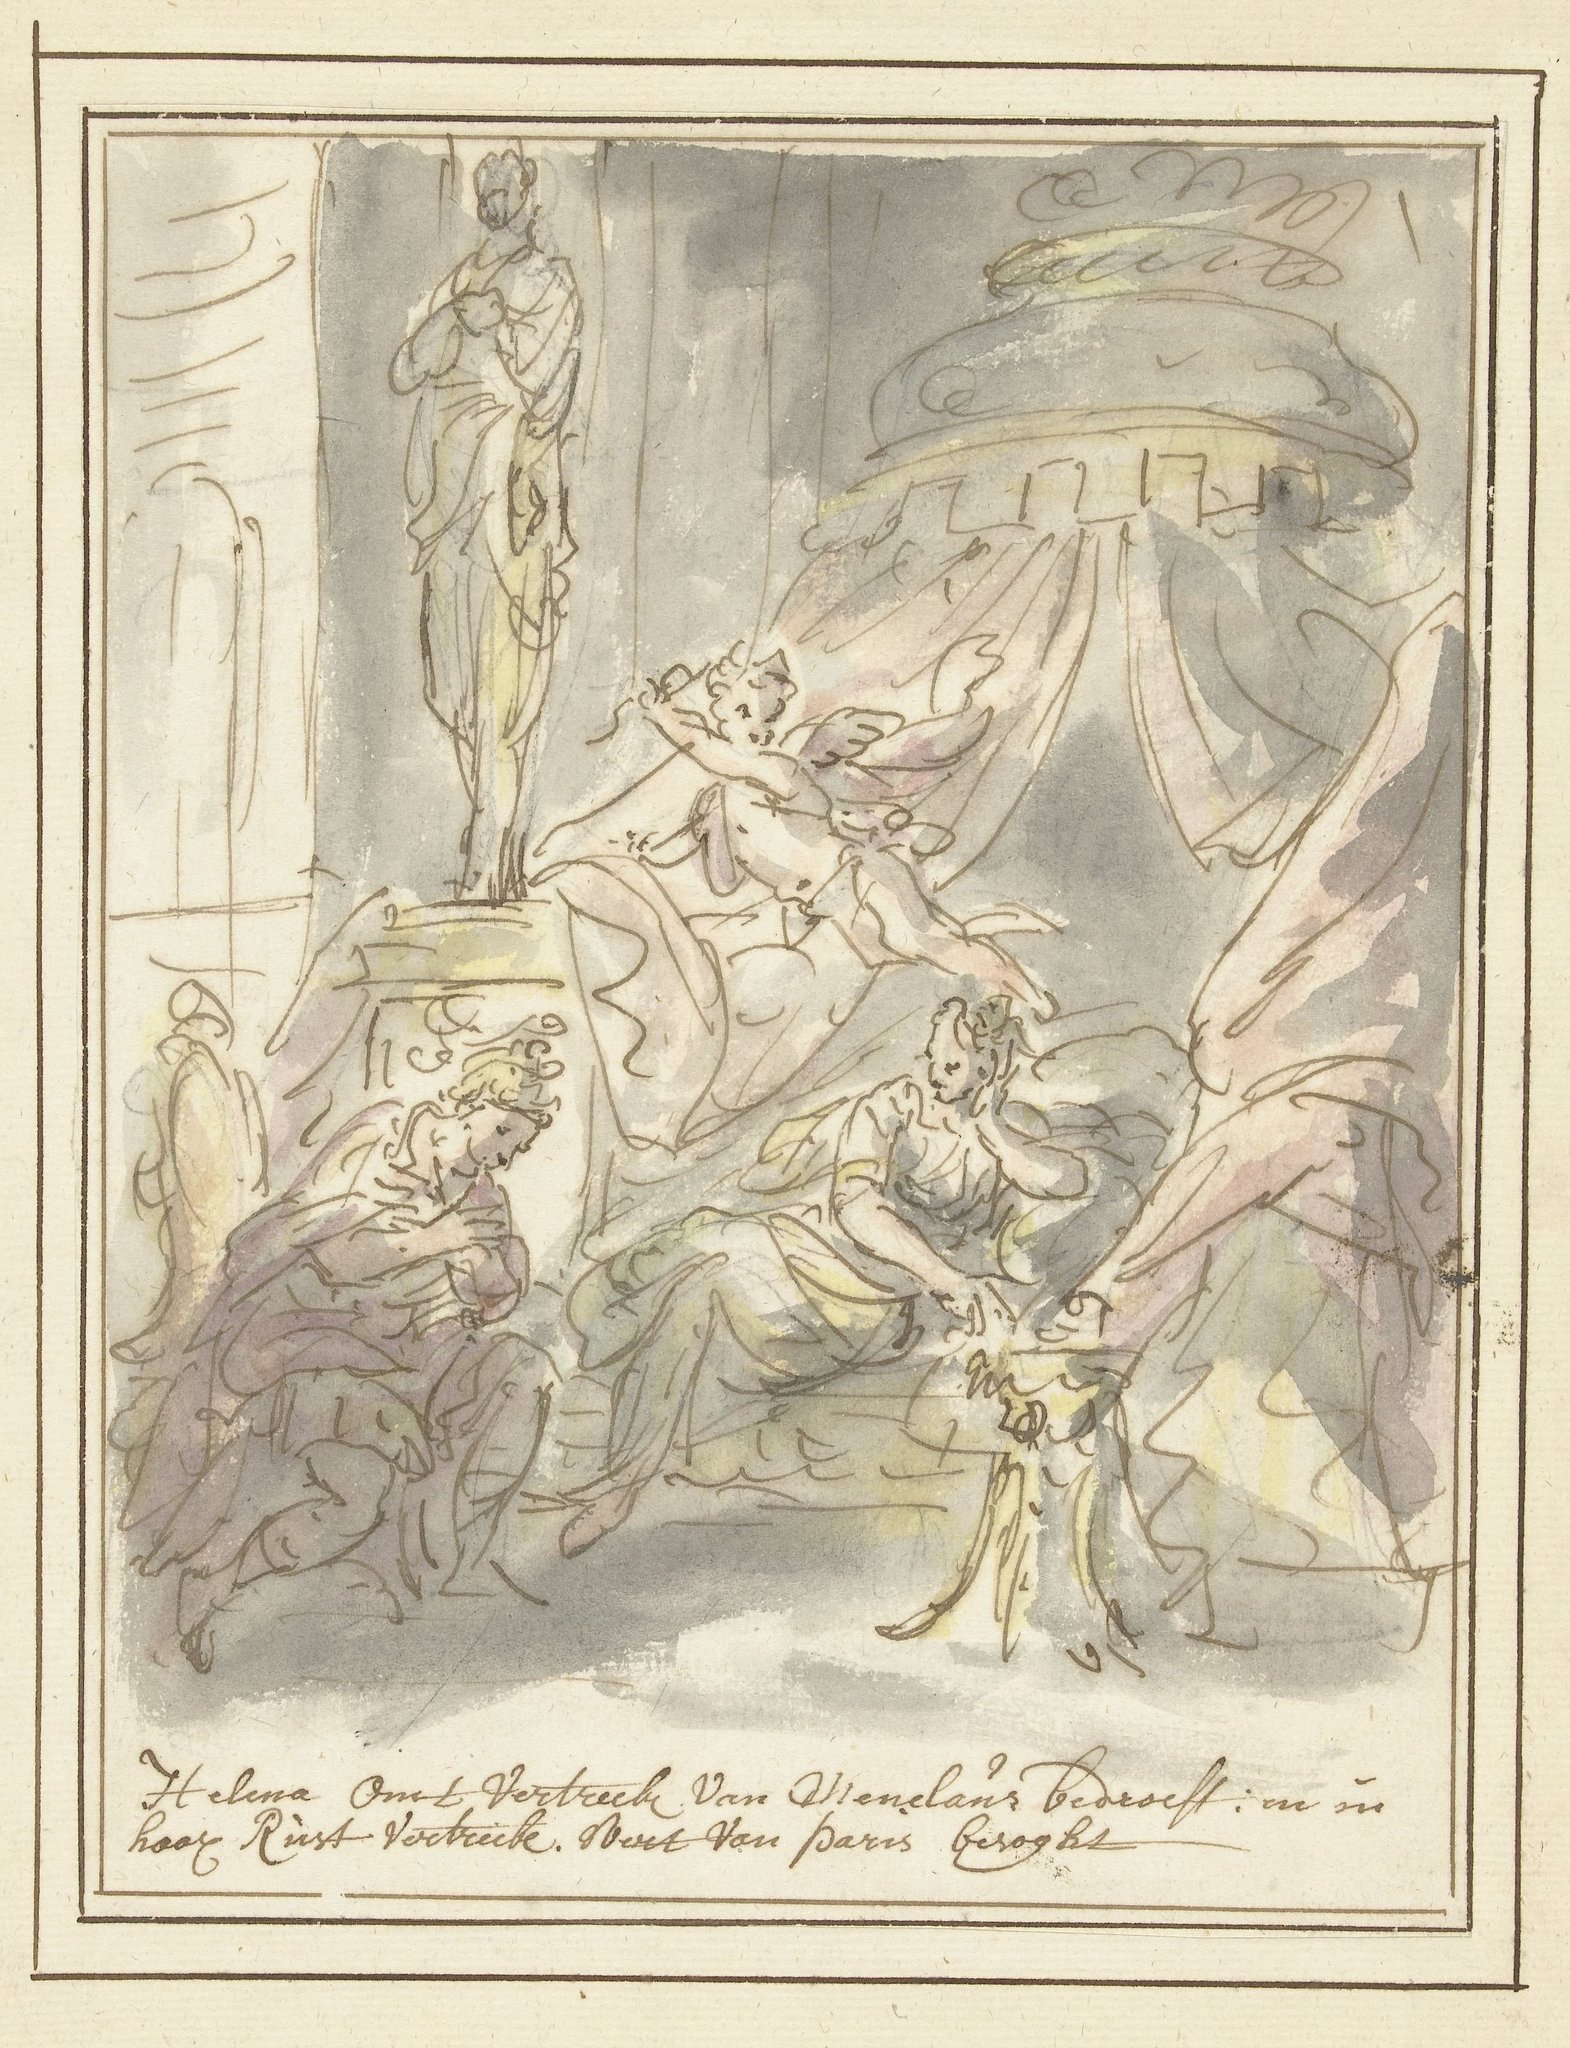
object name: drawing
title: Paris troost Helena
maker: elias van nijmegen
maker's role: draughtsman, painter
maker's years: 1667-1755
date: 1677-1755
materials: ink, paper, pencil, watercolor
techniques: brush, pen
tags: paris in greece